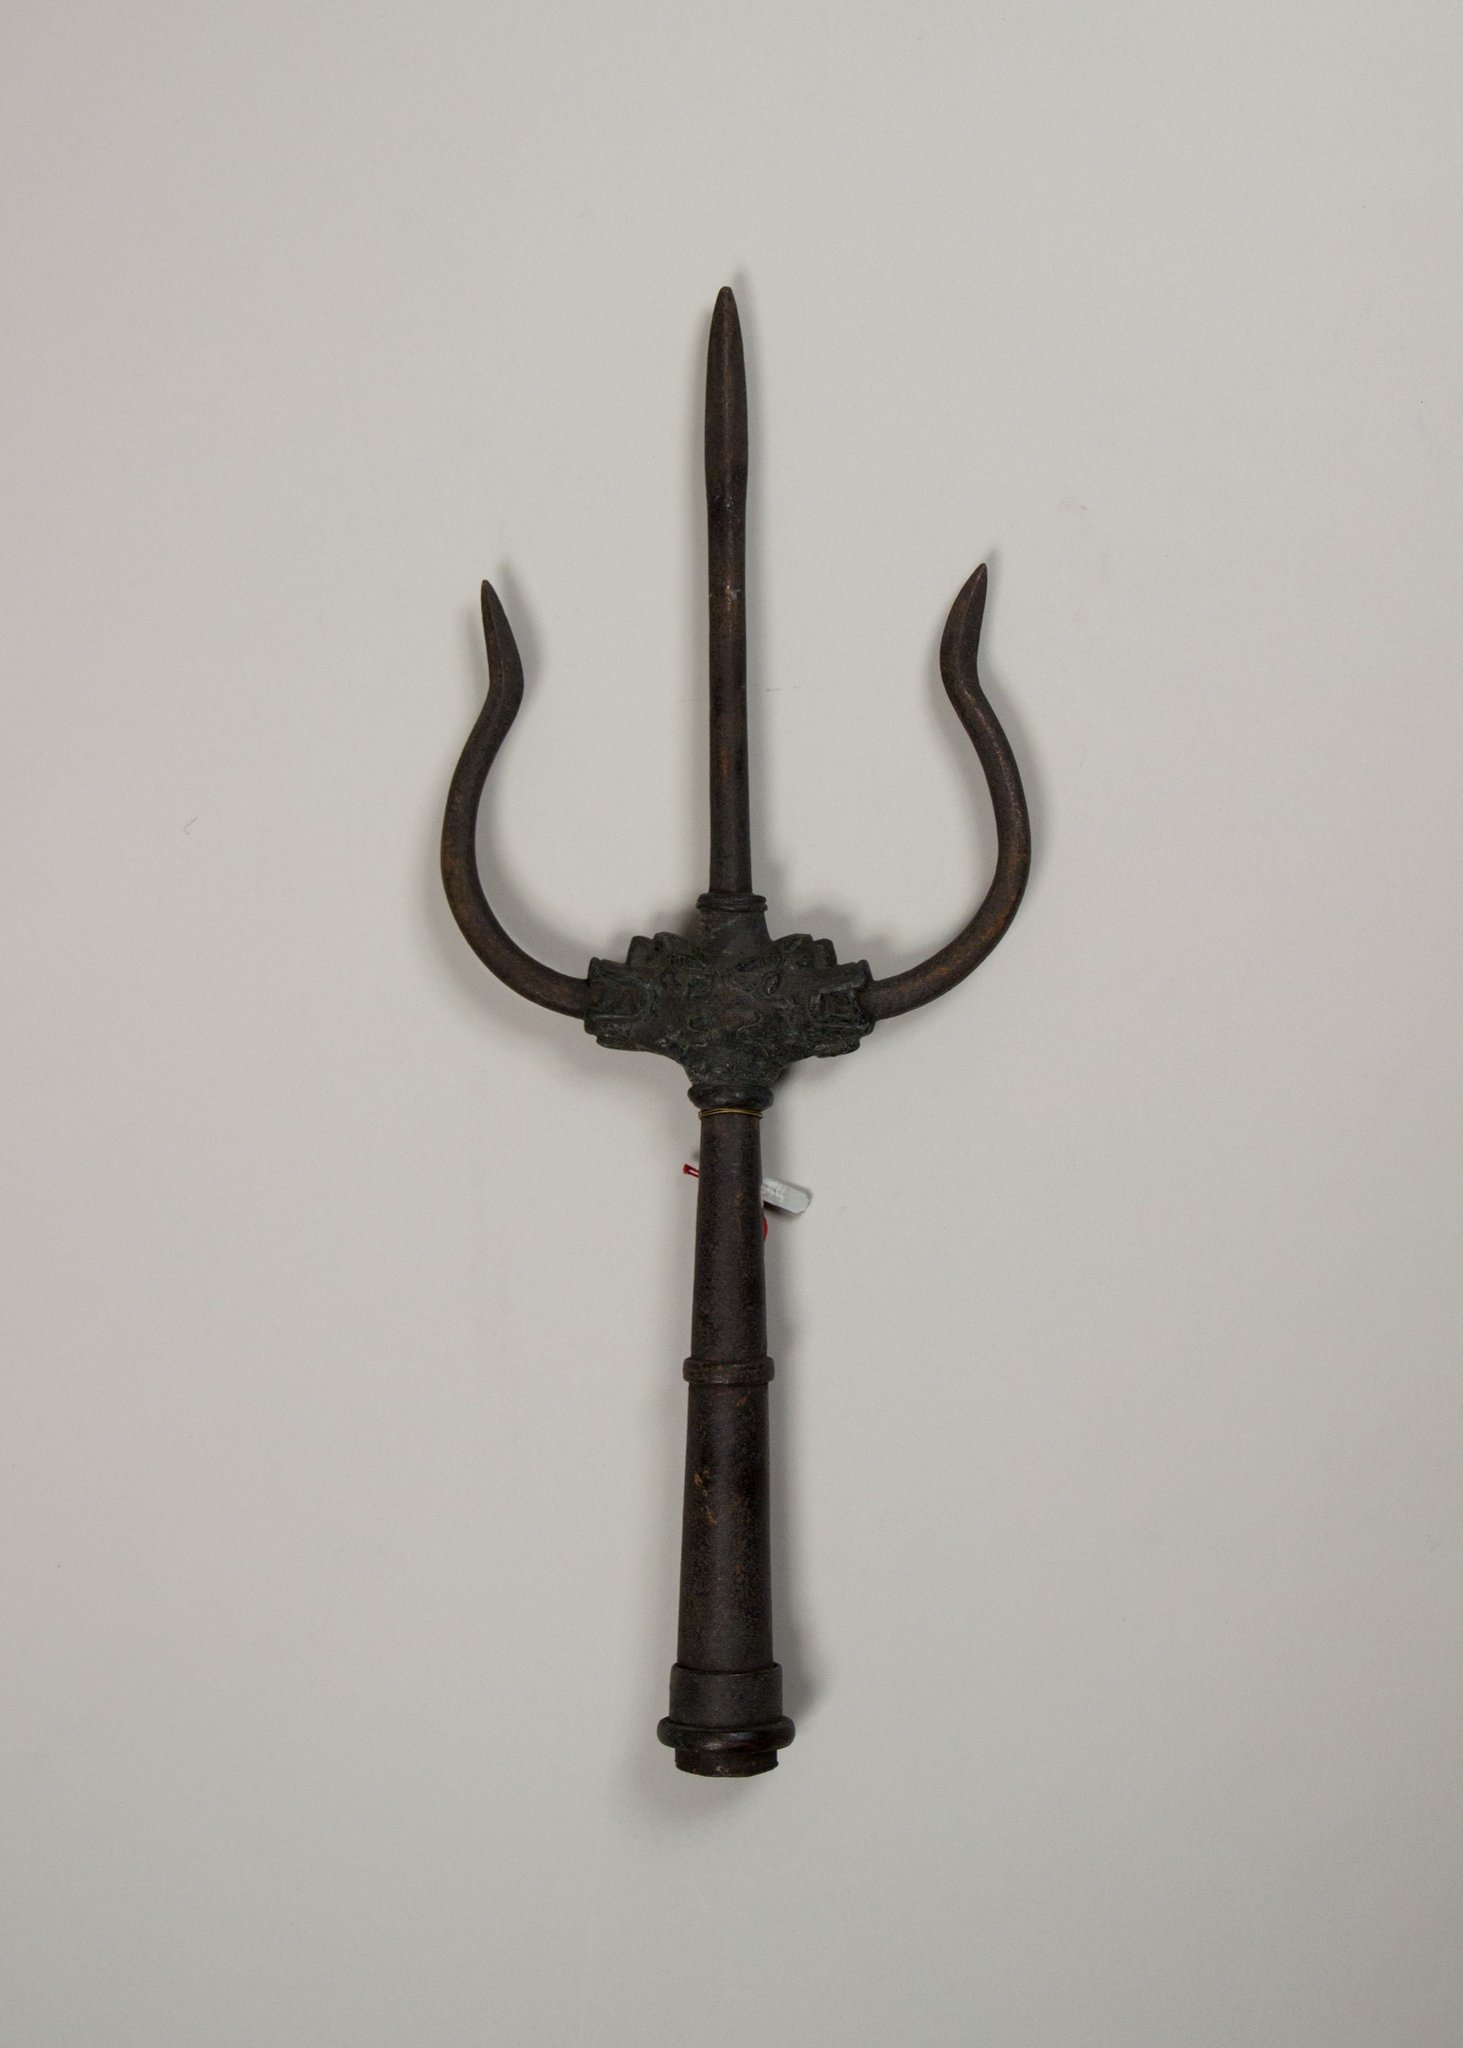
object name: trident head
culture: korean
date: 1501-1900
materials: bronze, steel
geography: korea